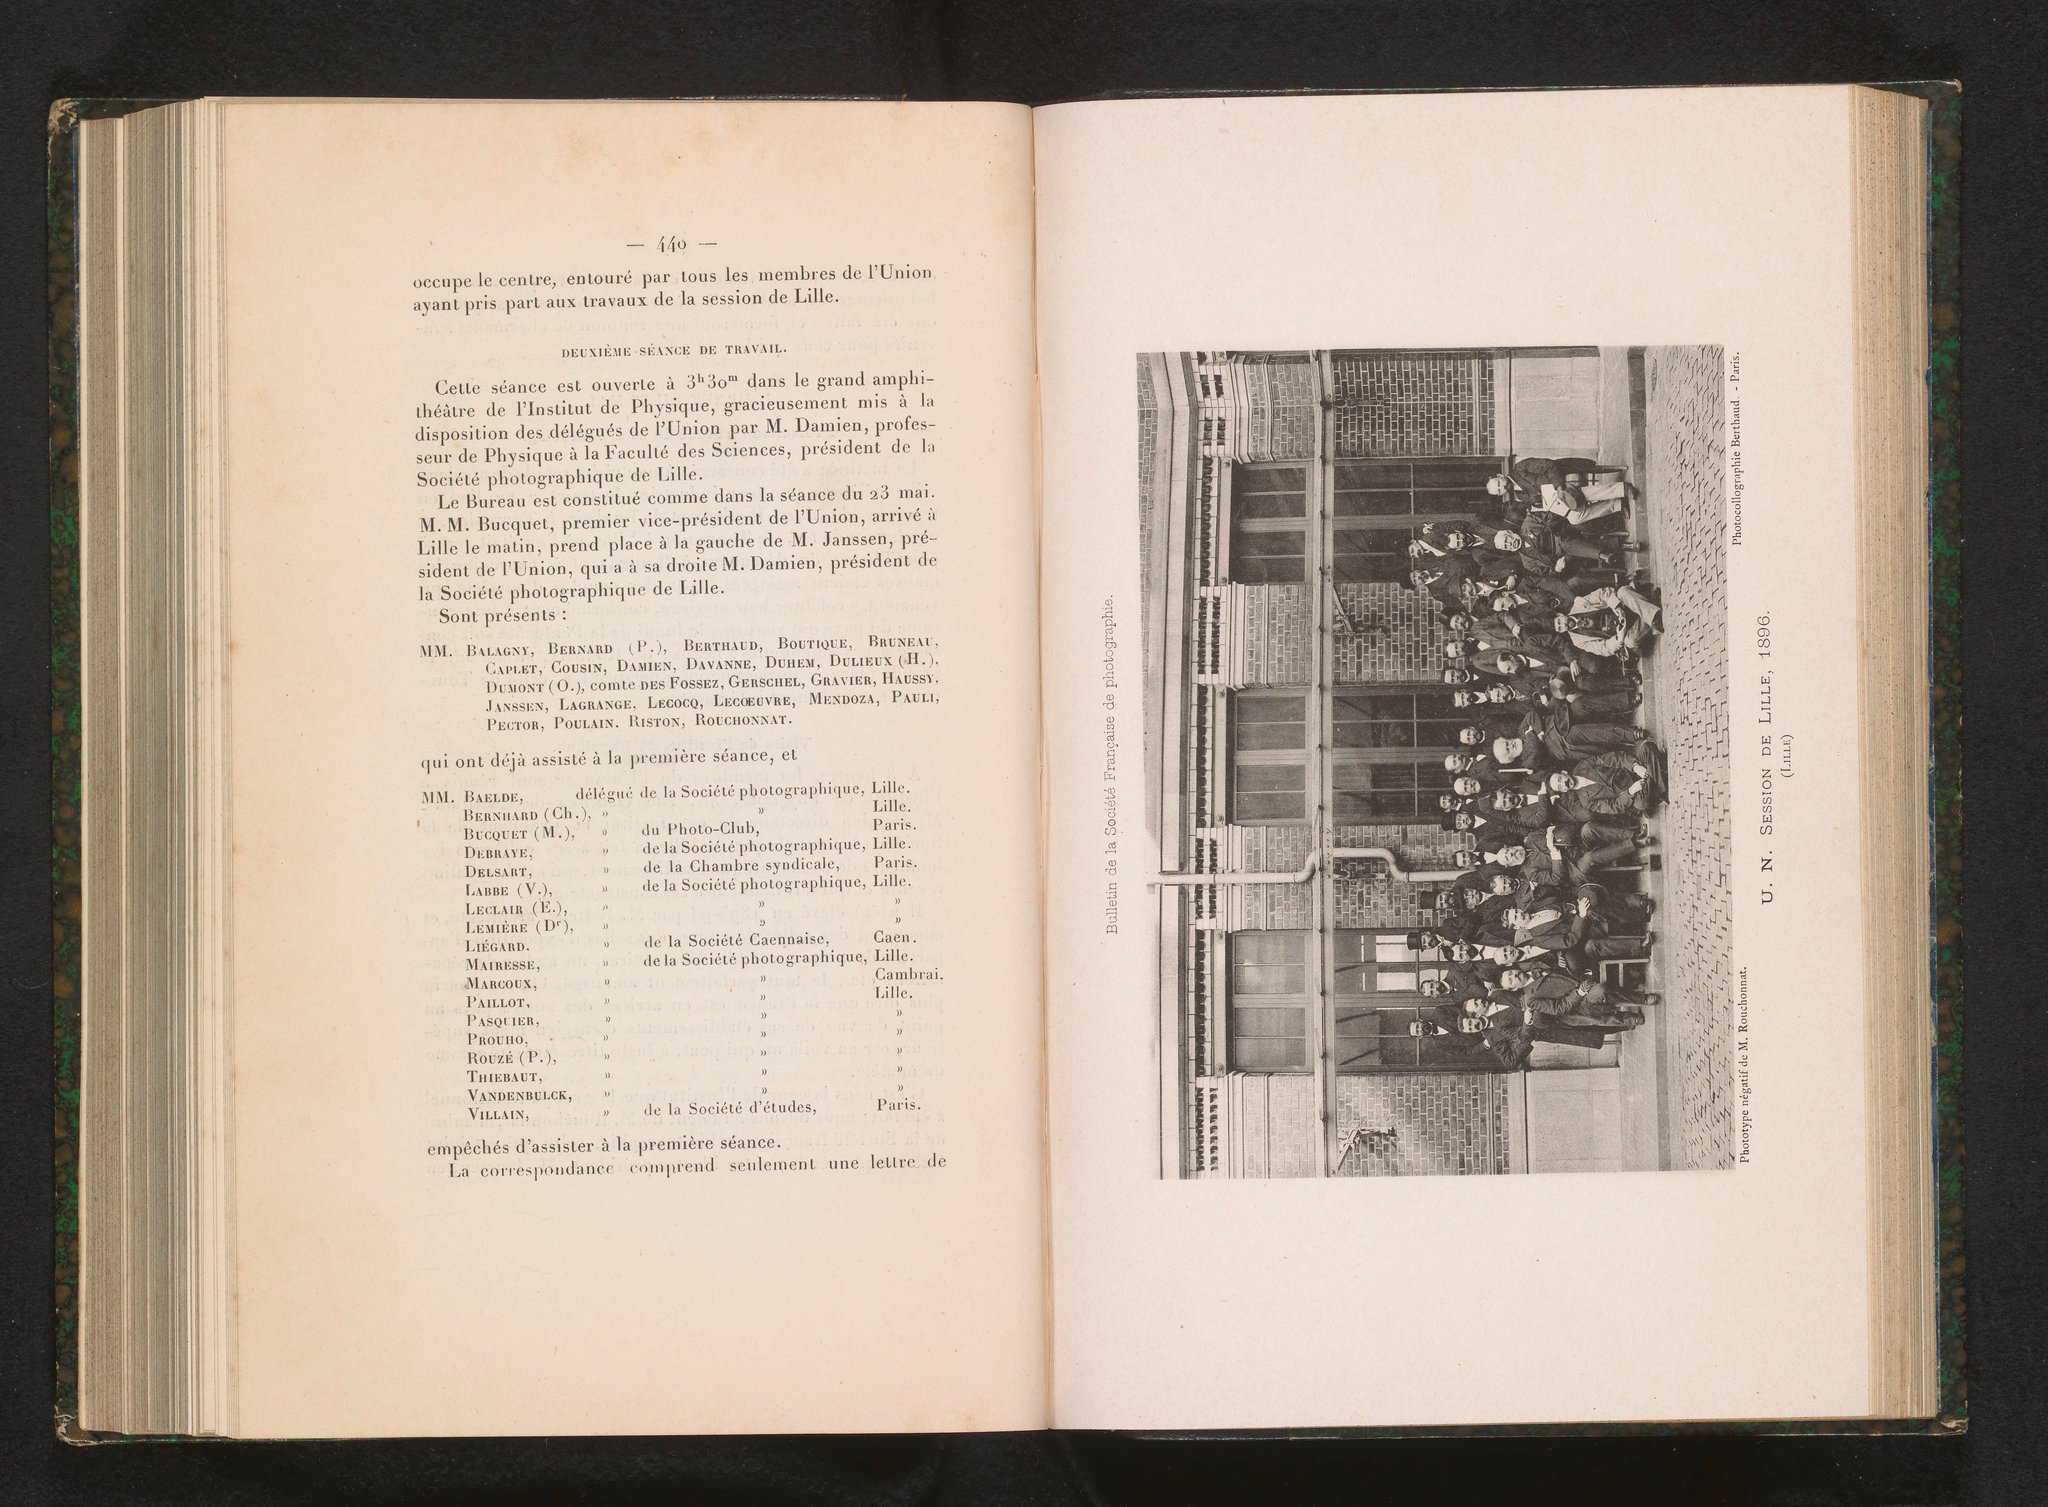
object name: photomechanical print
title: Groepsportret van leden van de Union Nationale de Photographie te Lille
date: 1896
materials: paper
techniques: photograph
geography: paris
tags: façade (of house or building), anonymous historical persons portrayed in a group, in a group-portrait